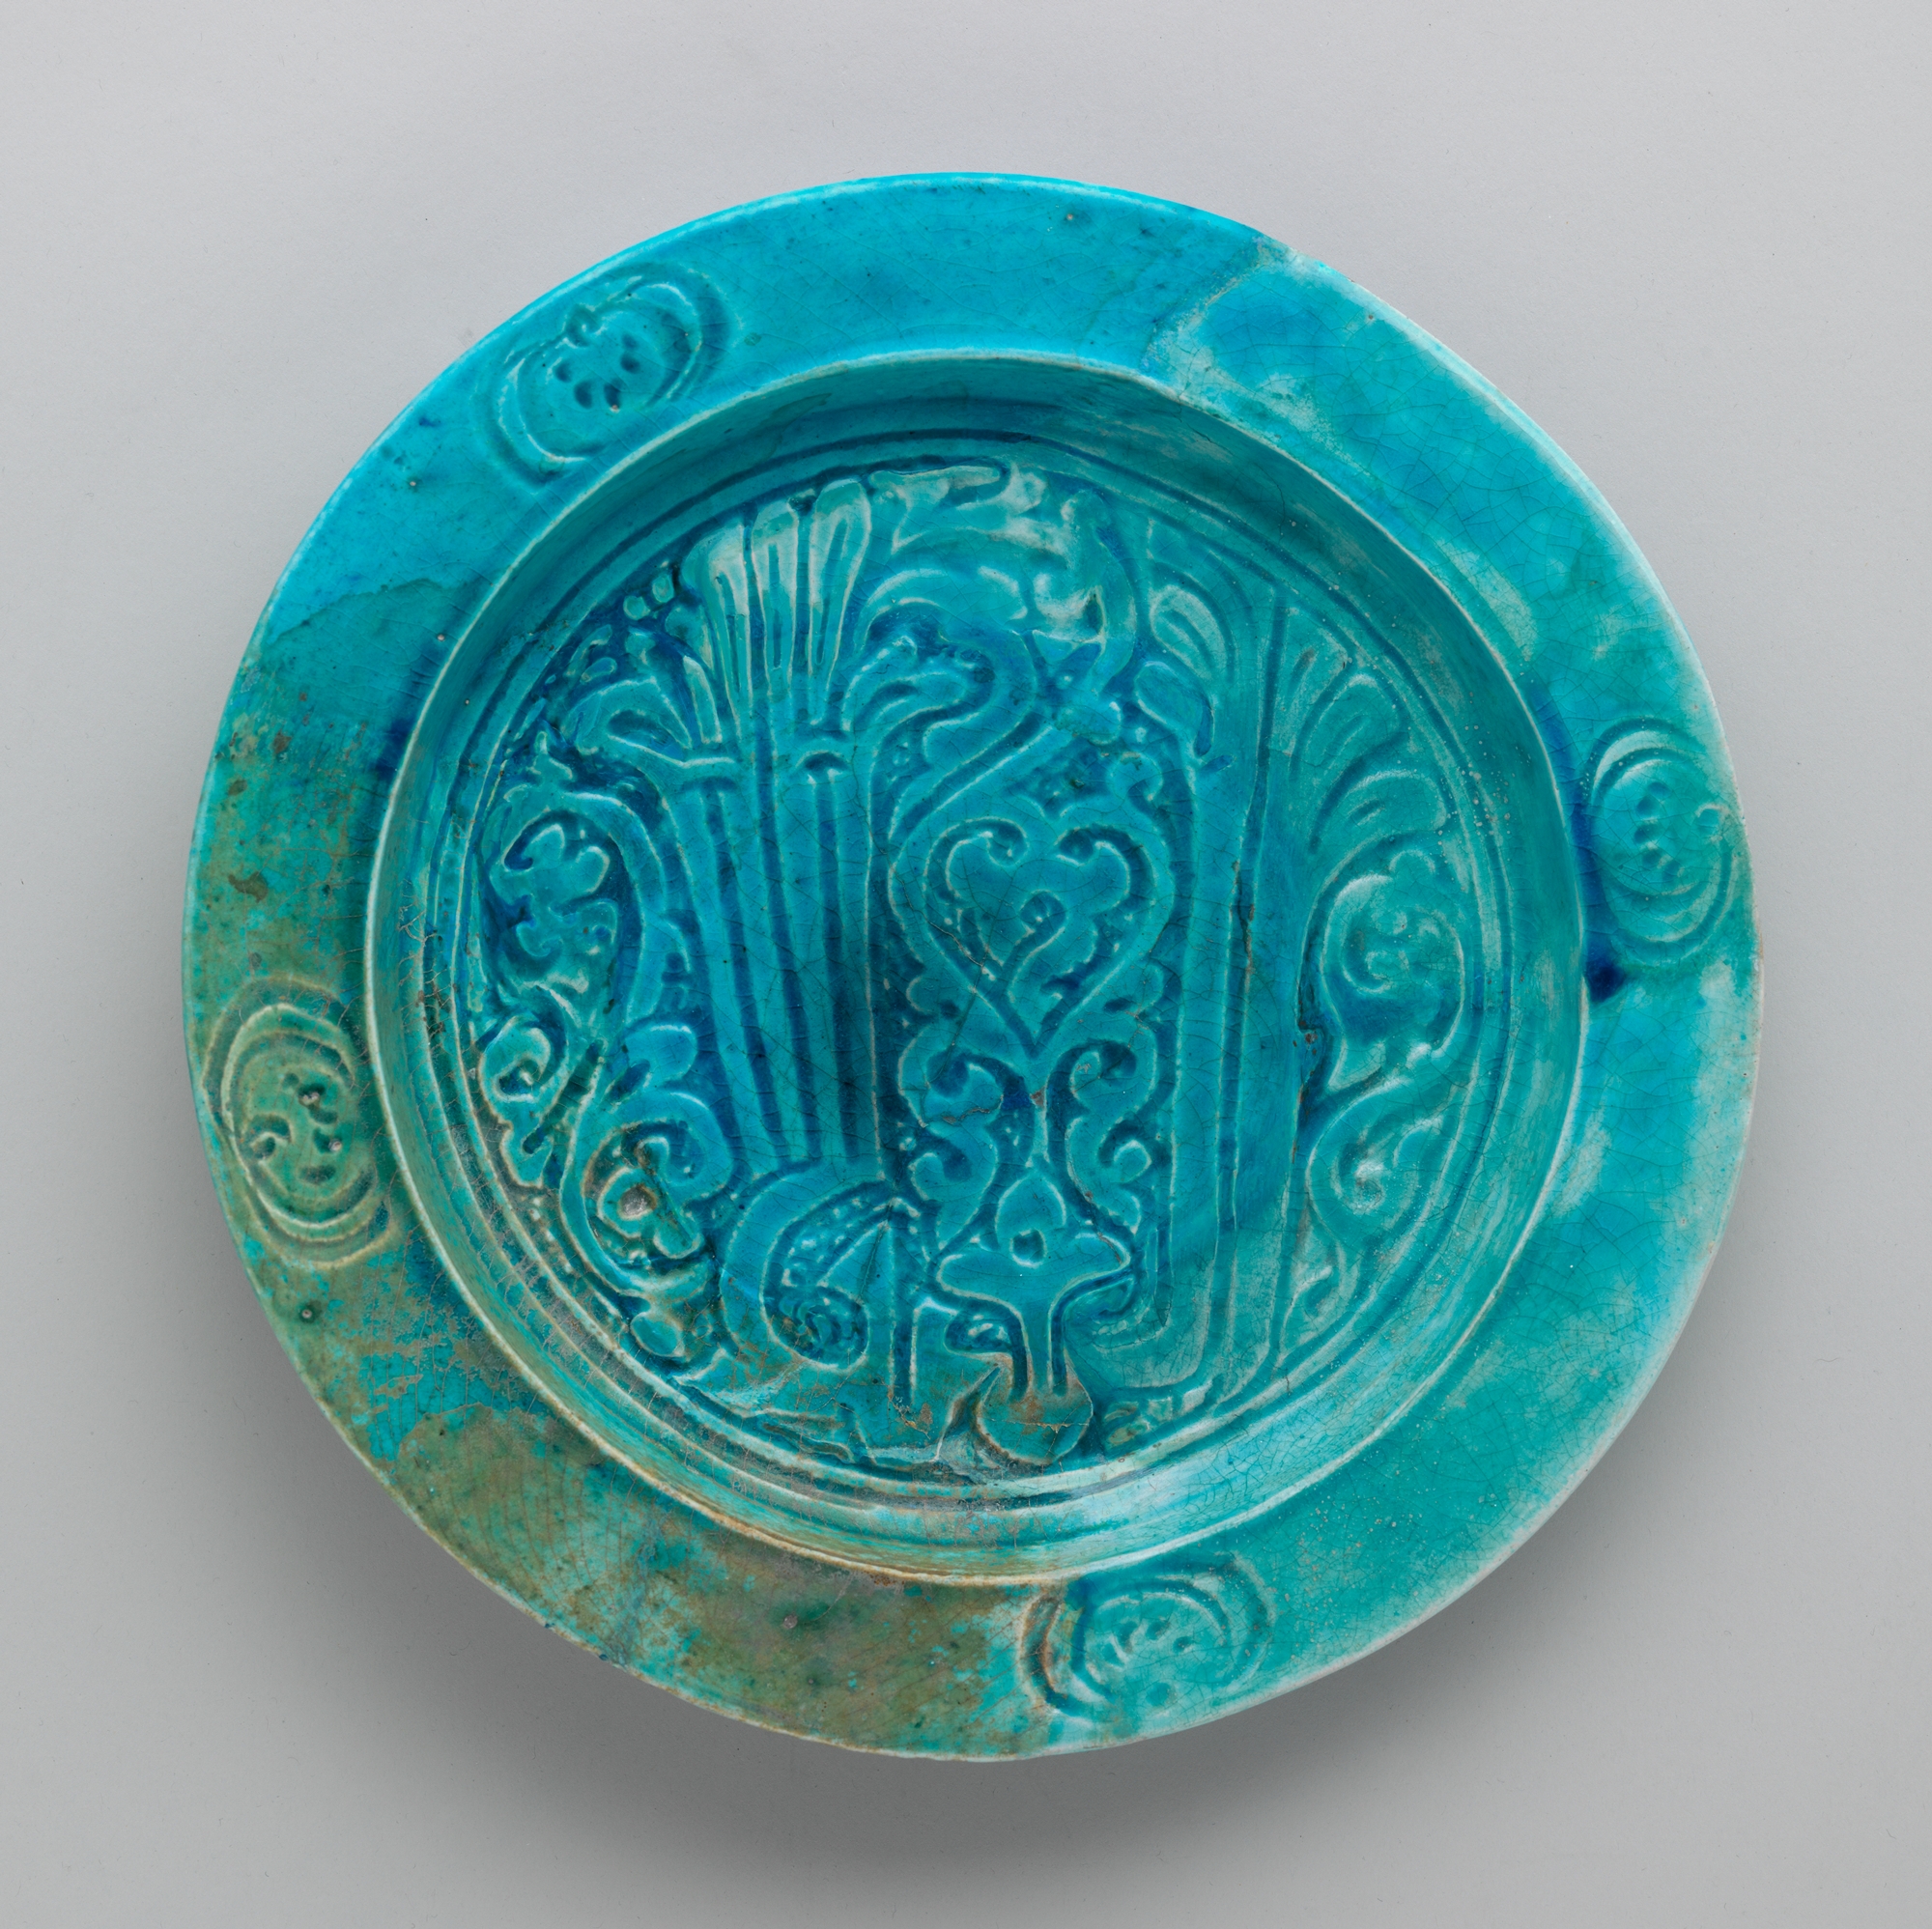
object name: dish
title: Dish with Carved Arabic Inscription in Floriated Kufic Reading "al-'izz" ("Glory")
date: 1001-1100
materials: stonepaste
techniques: carving, glazing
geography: iran